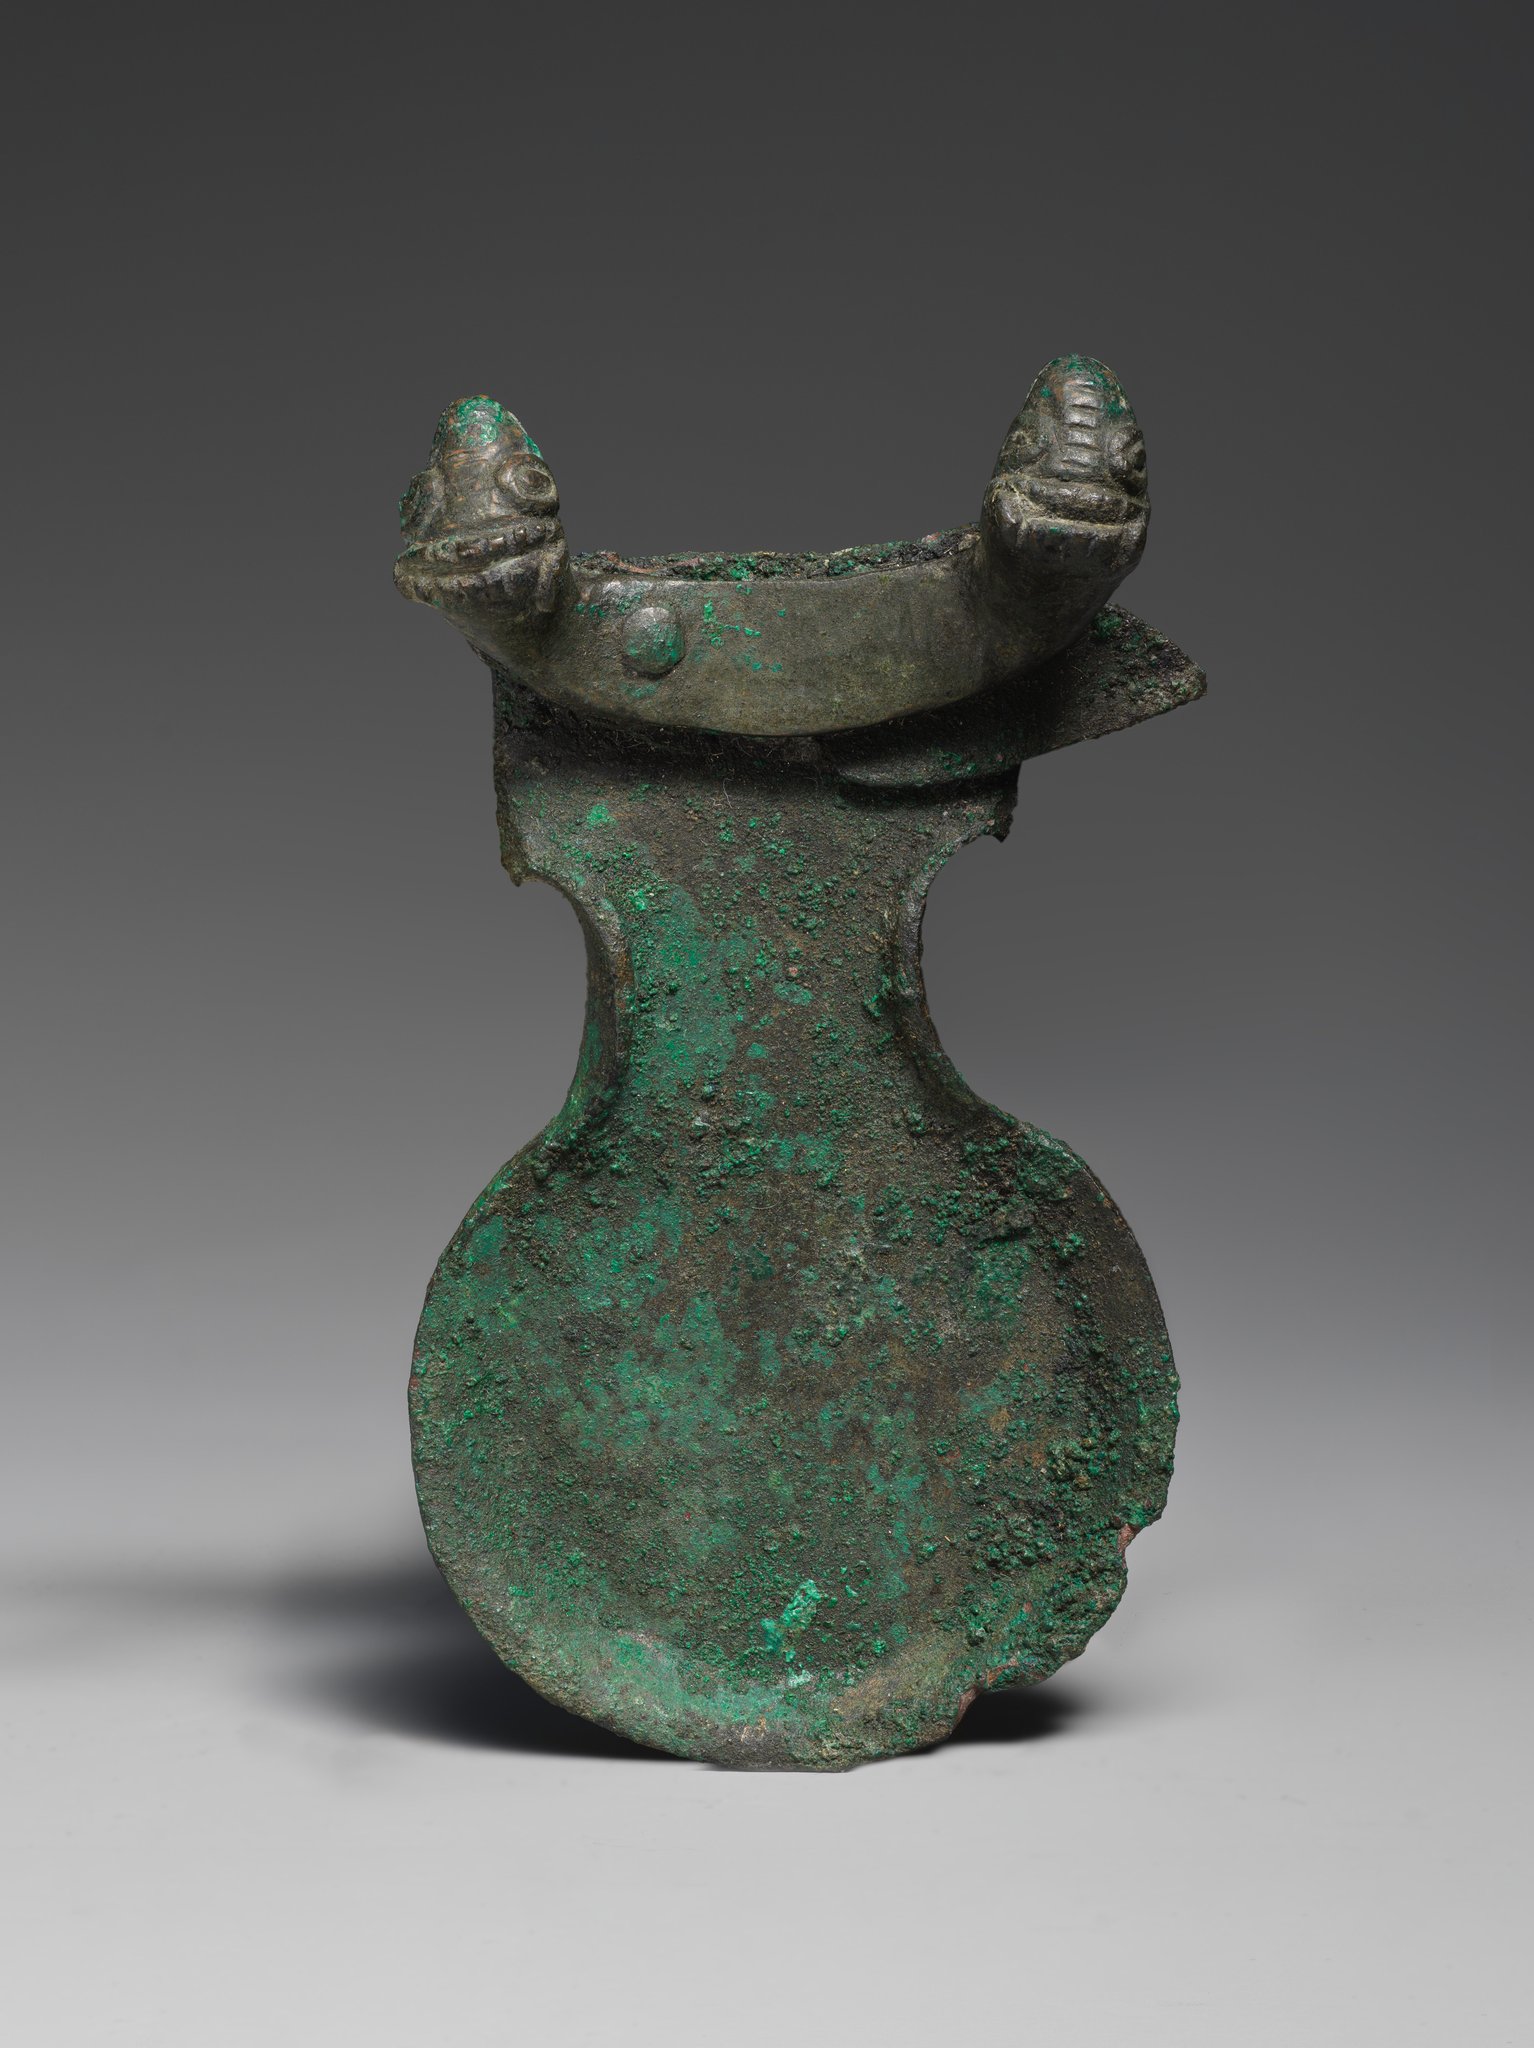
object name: handle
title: Handle (?)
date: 1-1000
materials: bronze